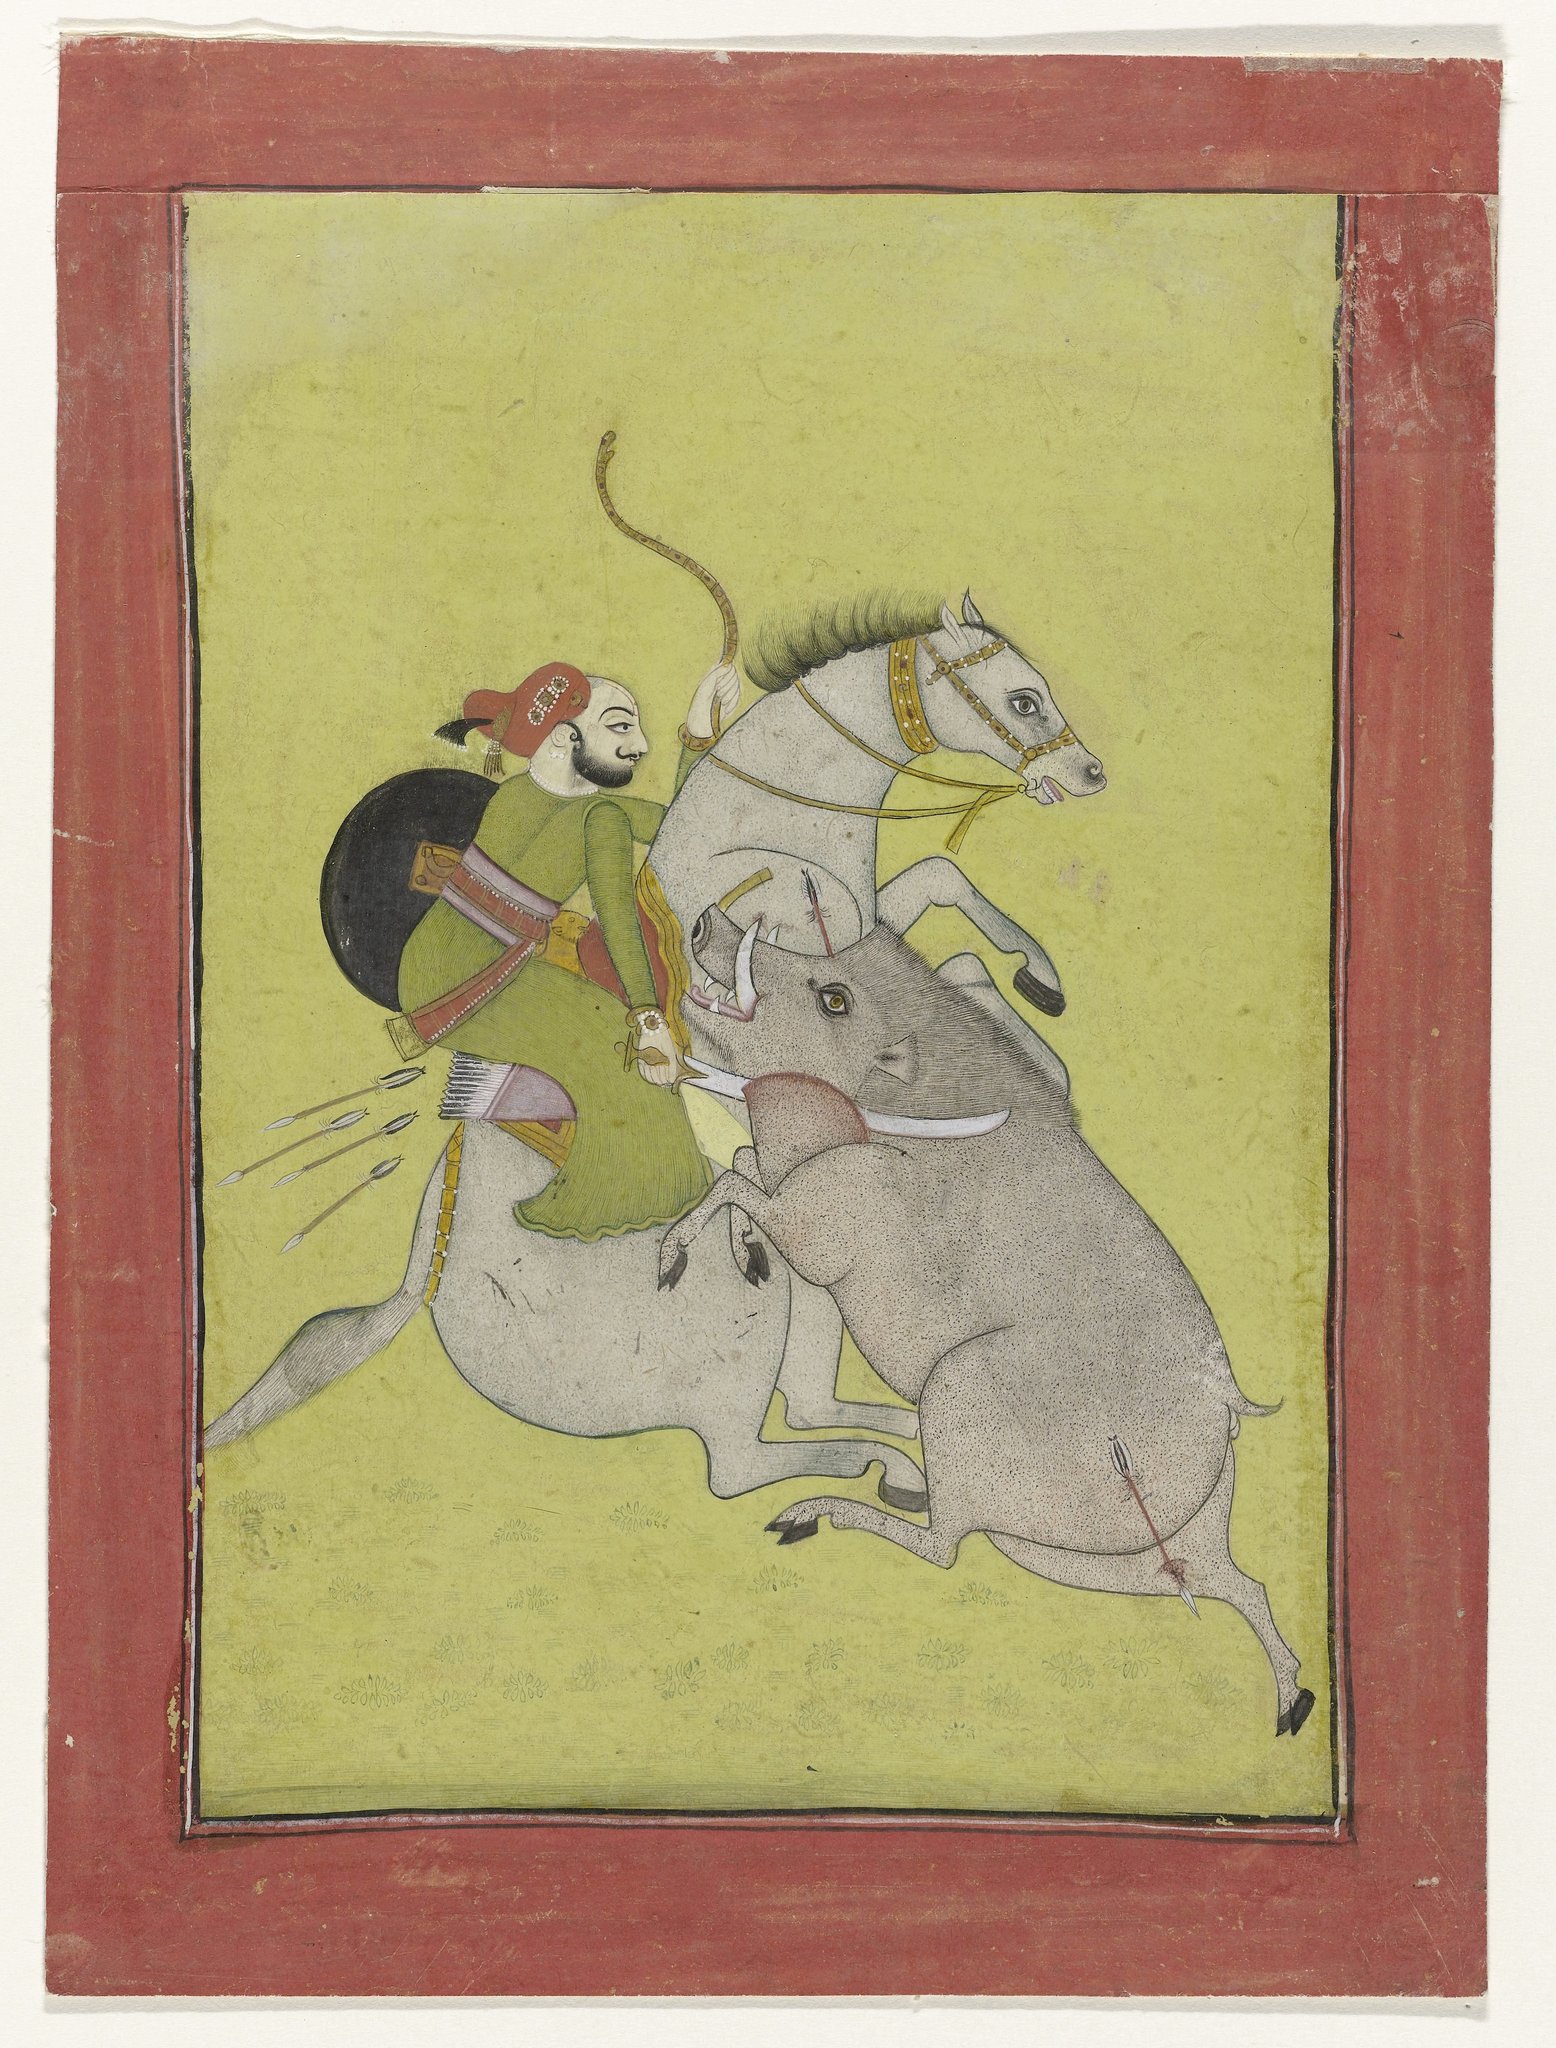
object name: indian miniature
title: Maharao Umed Singh of Bundi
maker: Anonymous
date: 1785-1795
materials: paint, gouache, paper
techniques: brush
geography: bundi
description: The ruler Umed Singh’s (1743-1804) passion for horsemanship was well known. The maharao (a Hindu ruler in India) is here portrayed from a high vantage point, lending the image a certain dynamism. This equestrian portrait differs greatly from the prevailing popular standard type, in which the rider and horse are depicted parallel to the ground.